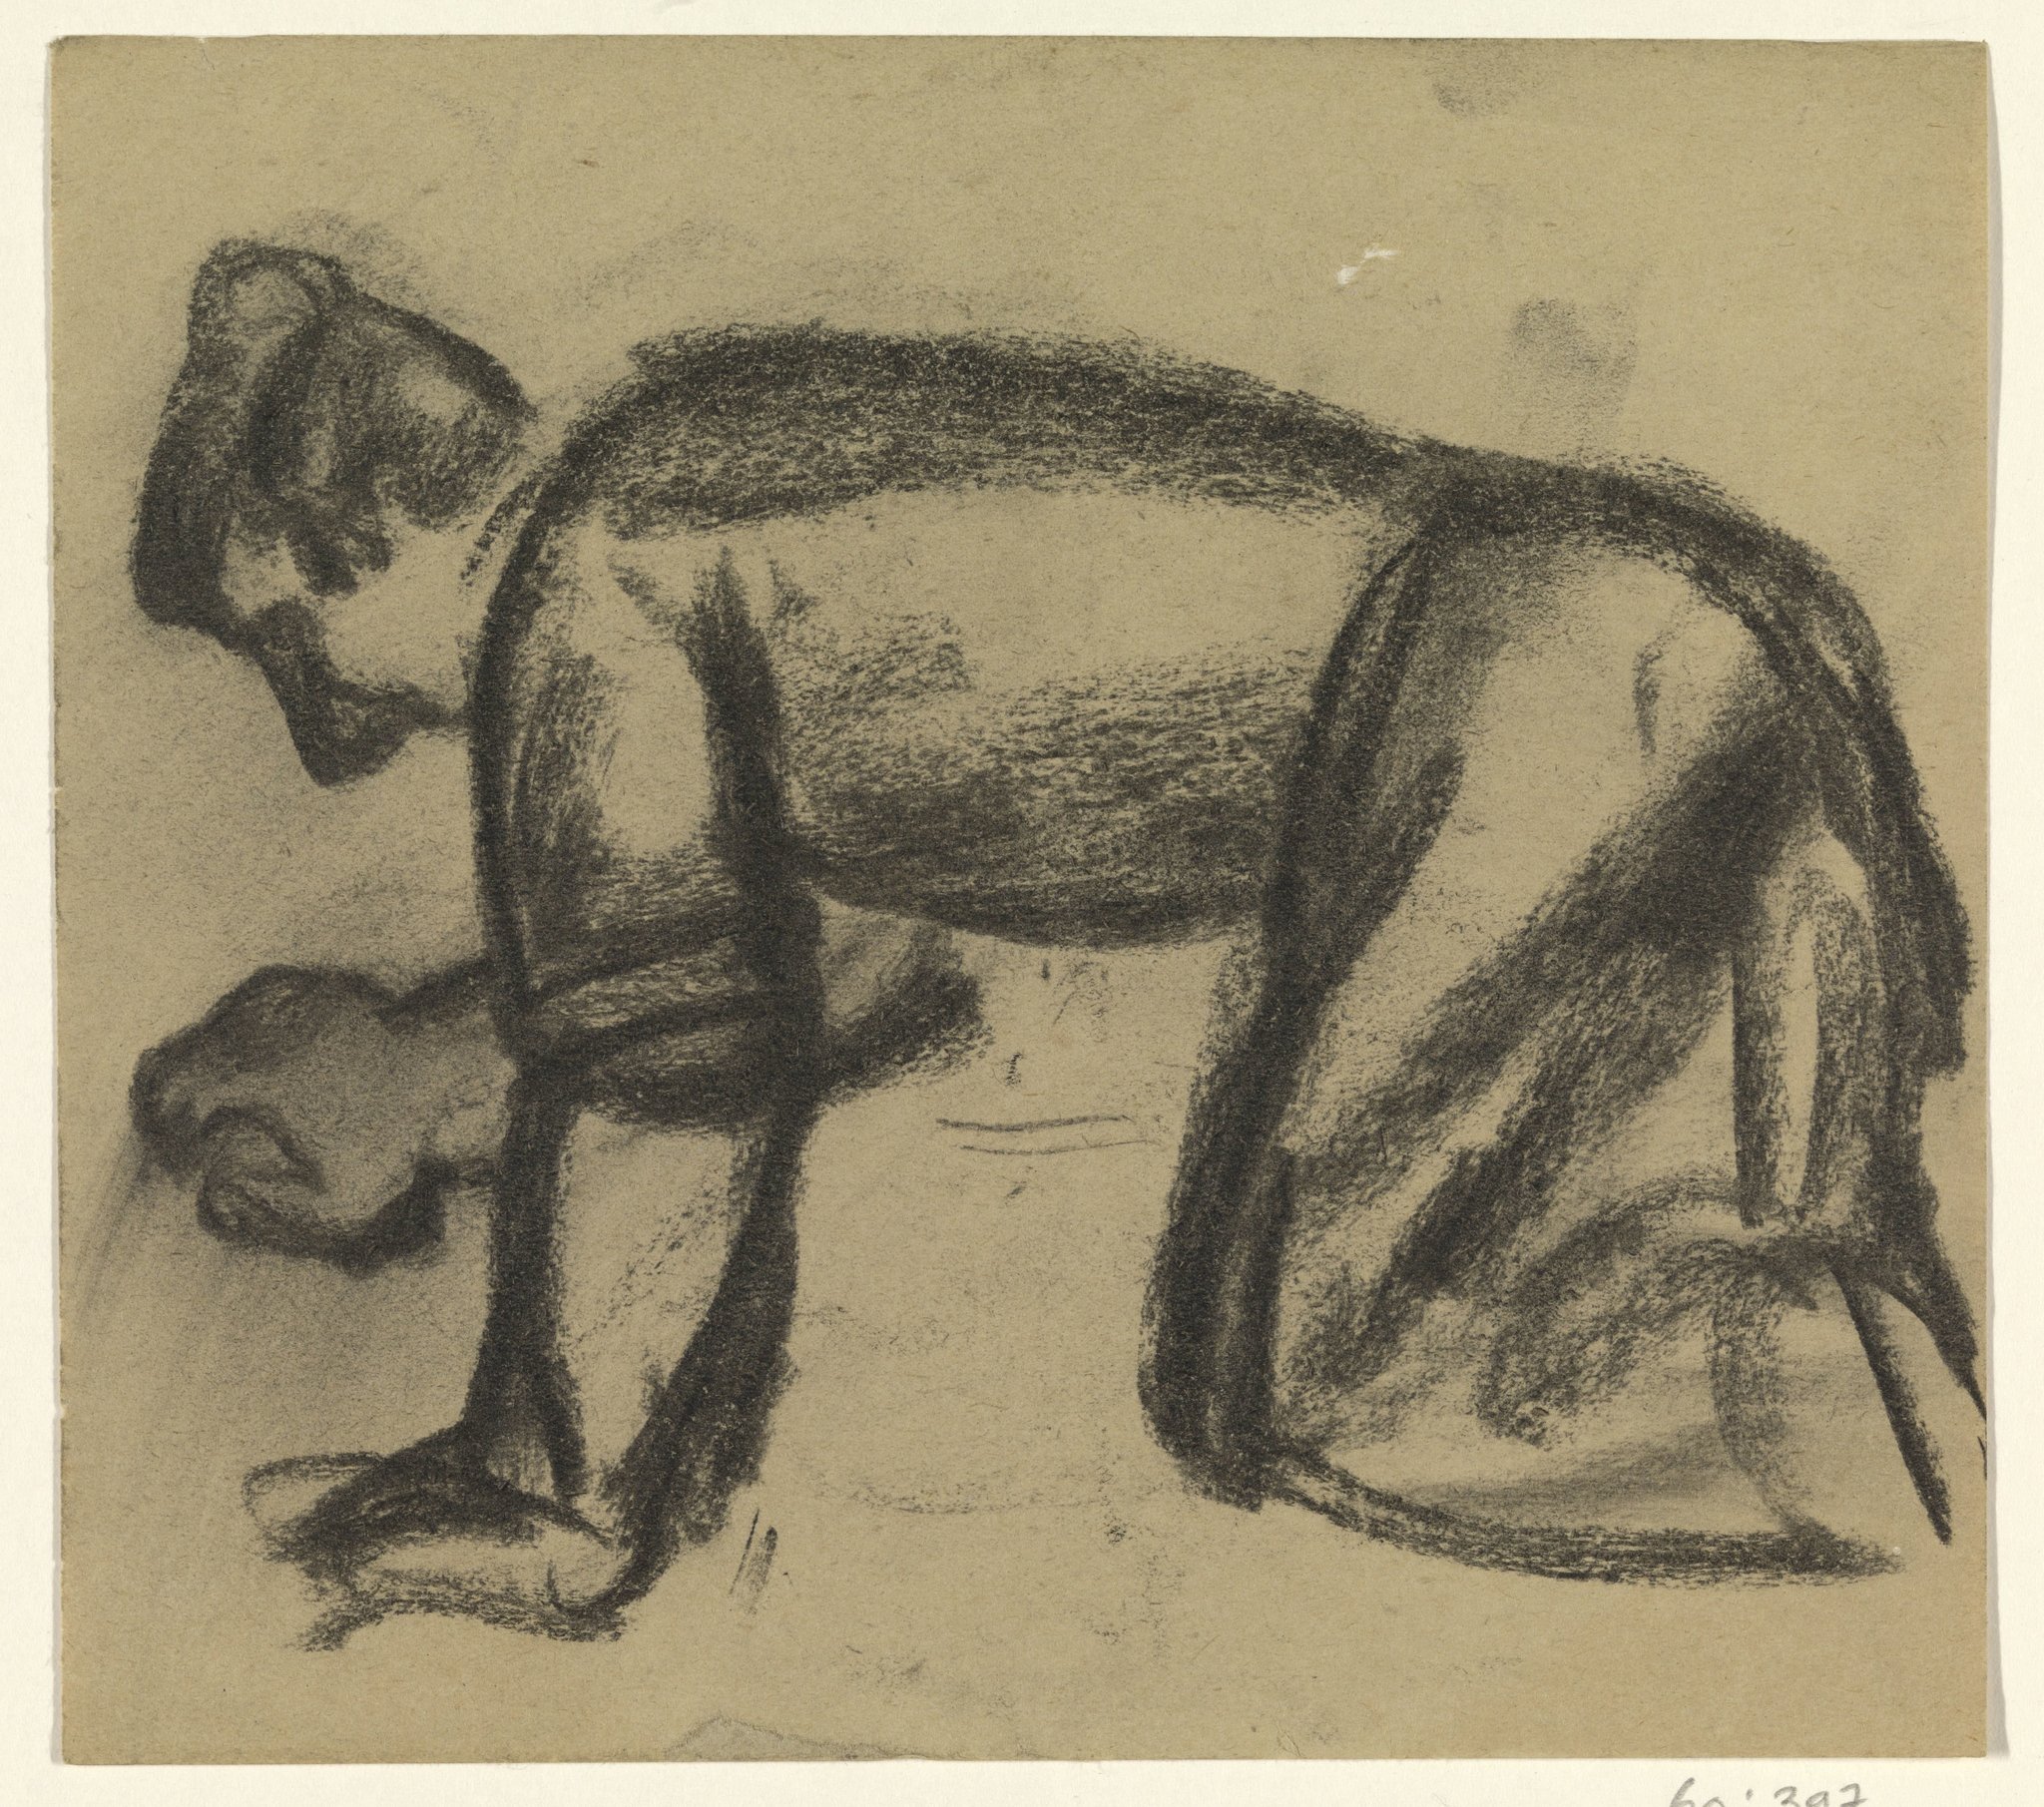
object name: drawing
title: Man op handen en knieën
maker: leo gestel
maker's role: draughtsman, print maker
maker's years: 1881-1941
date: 1891-1941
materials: charcoal, paper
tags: kneeling figure, male sex; man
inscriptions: collector's mark: Lugt 2228